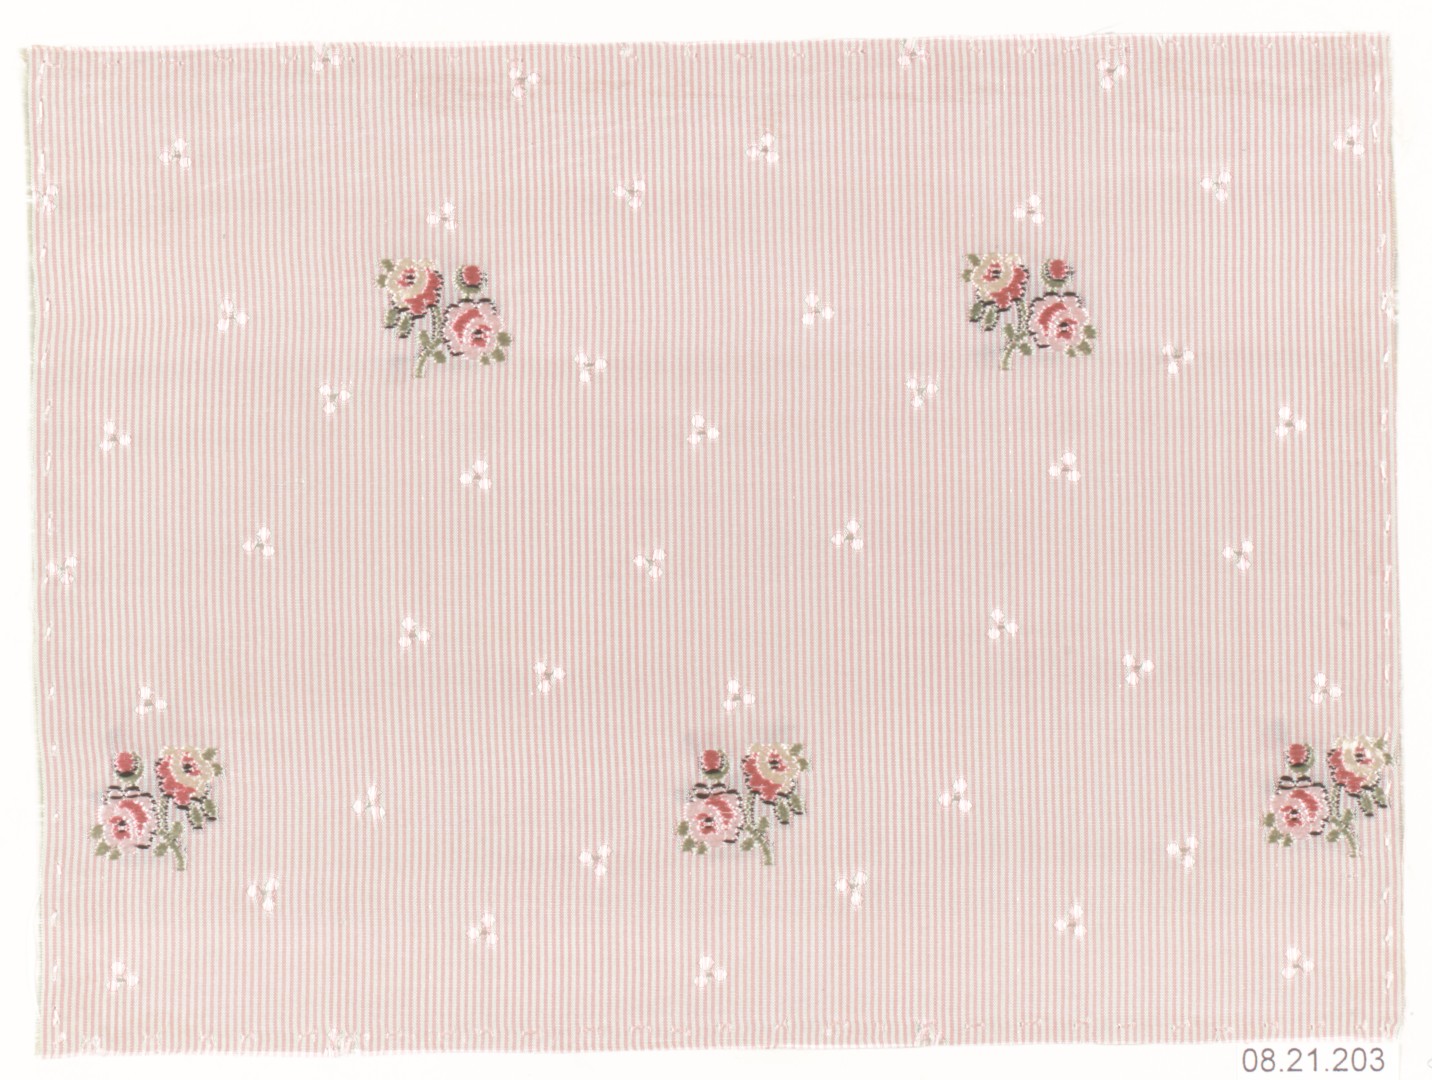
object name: textile sample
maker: Anonymous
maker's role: designer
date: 1900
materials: silk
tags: flowers